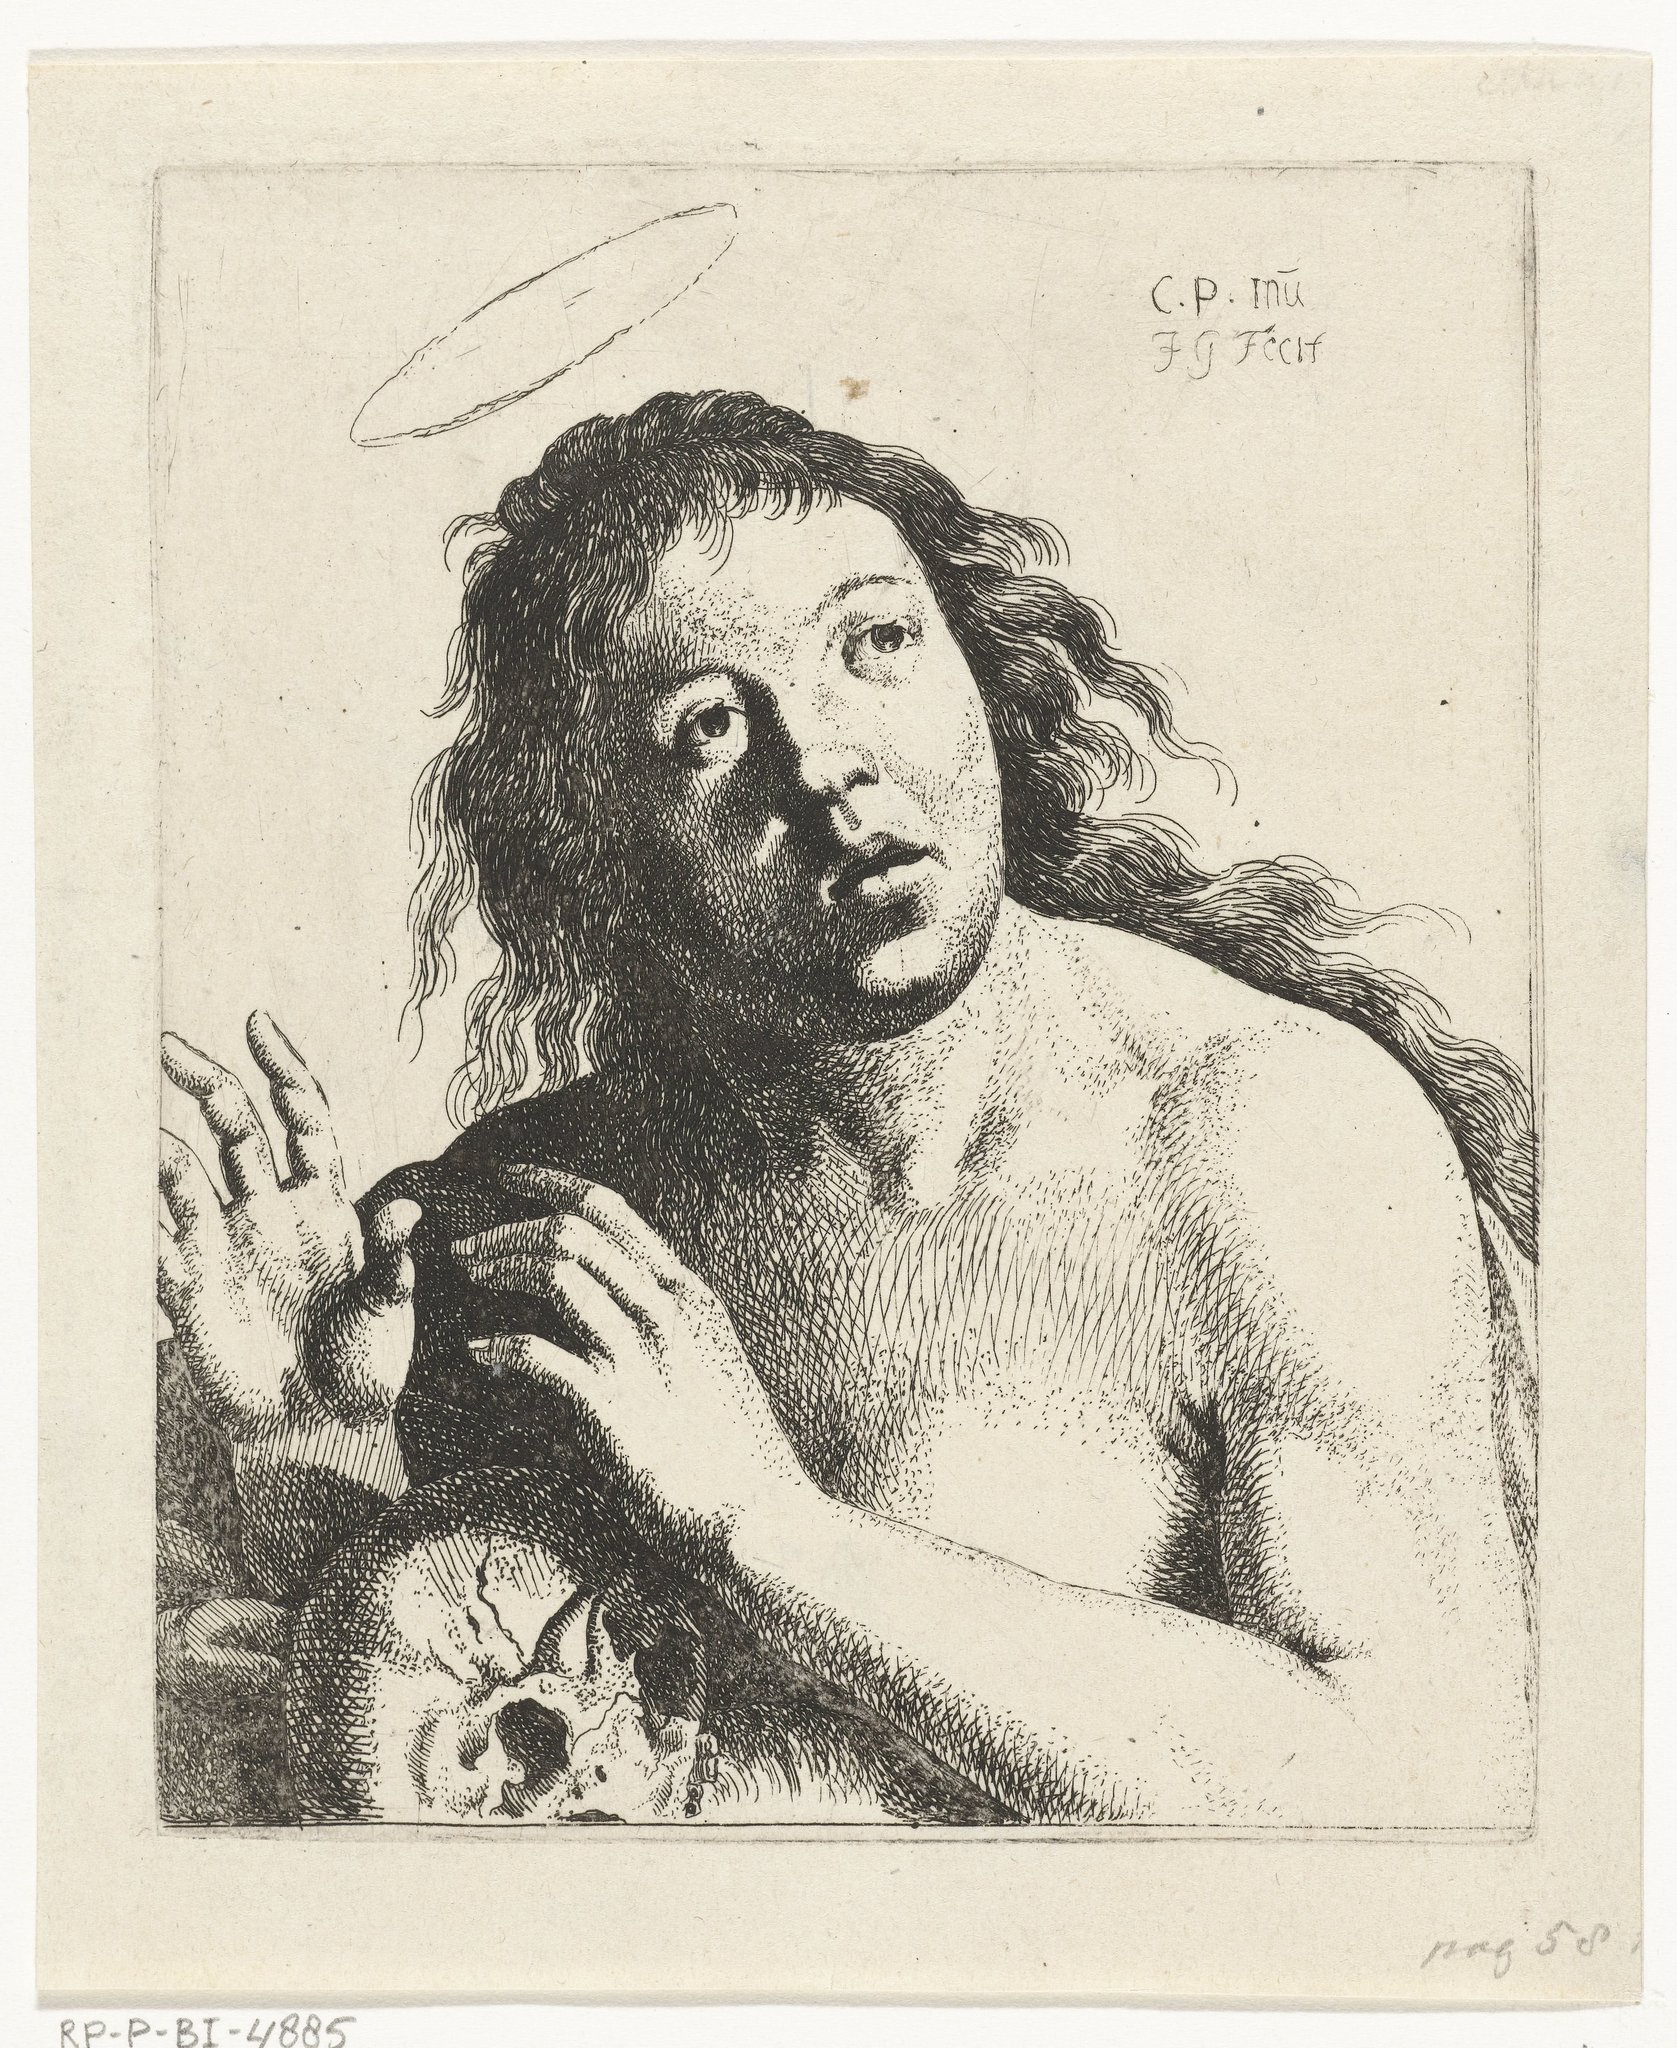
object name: print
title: Boetvaardige Maria Magdalena met schedel en aureool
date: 1613-1661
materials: paper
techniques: etching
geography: netherlands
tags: the penitent st. mary magdalene (often before a cave, possibly at la sainte-baume hill): her long hair covers her (naked) body, she reads, meditates or raises her tear-filled eyes towards heaven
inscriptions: collector's mark: Lugt 2228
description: Prent naar ontwerp van Cornelis van Poelenburch.